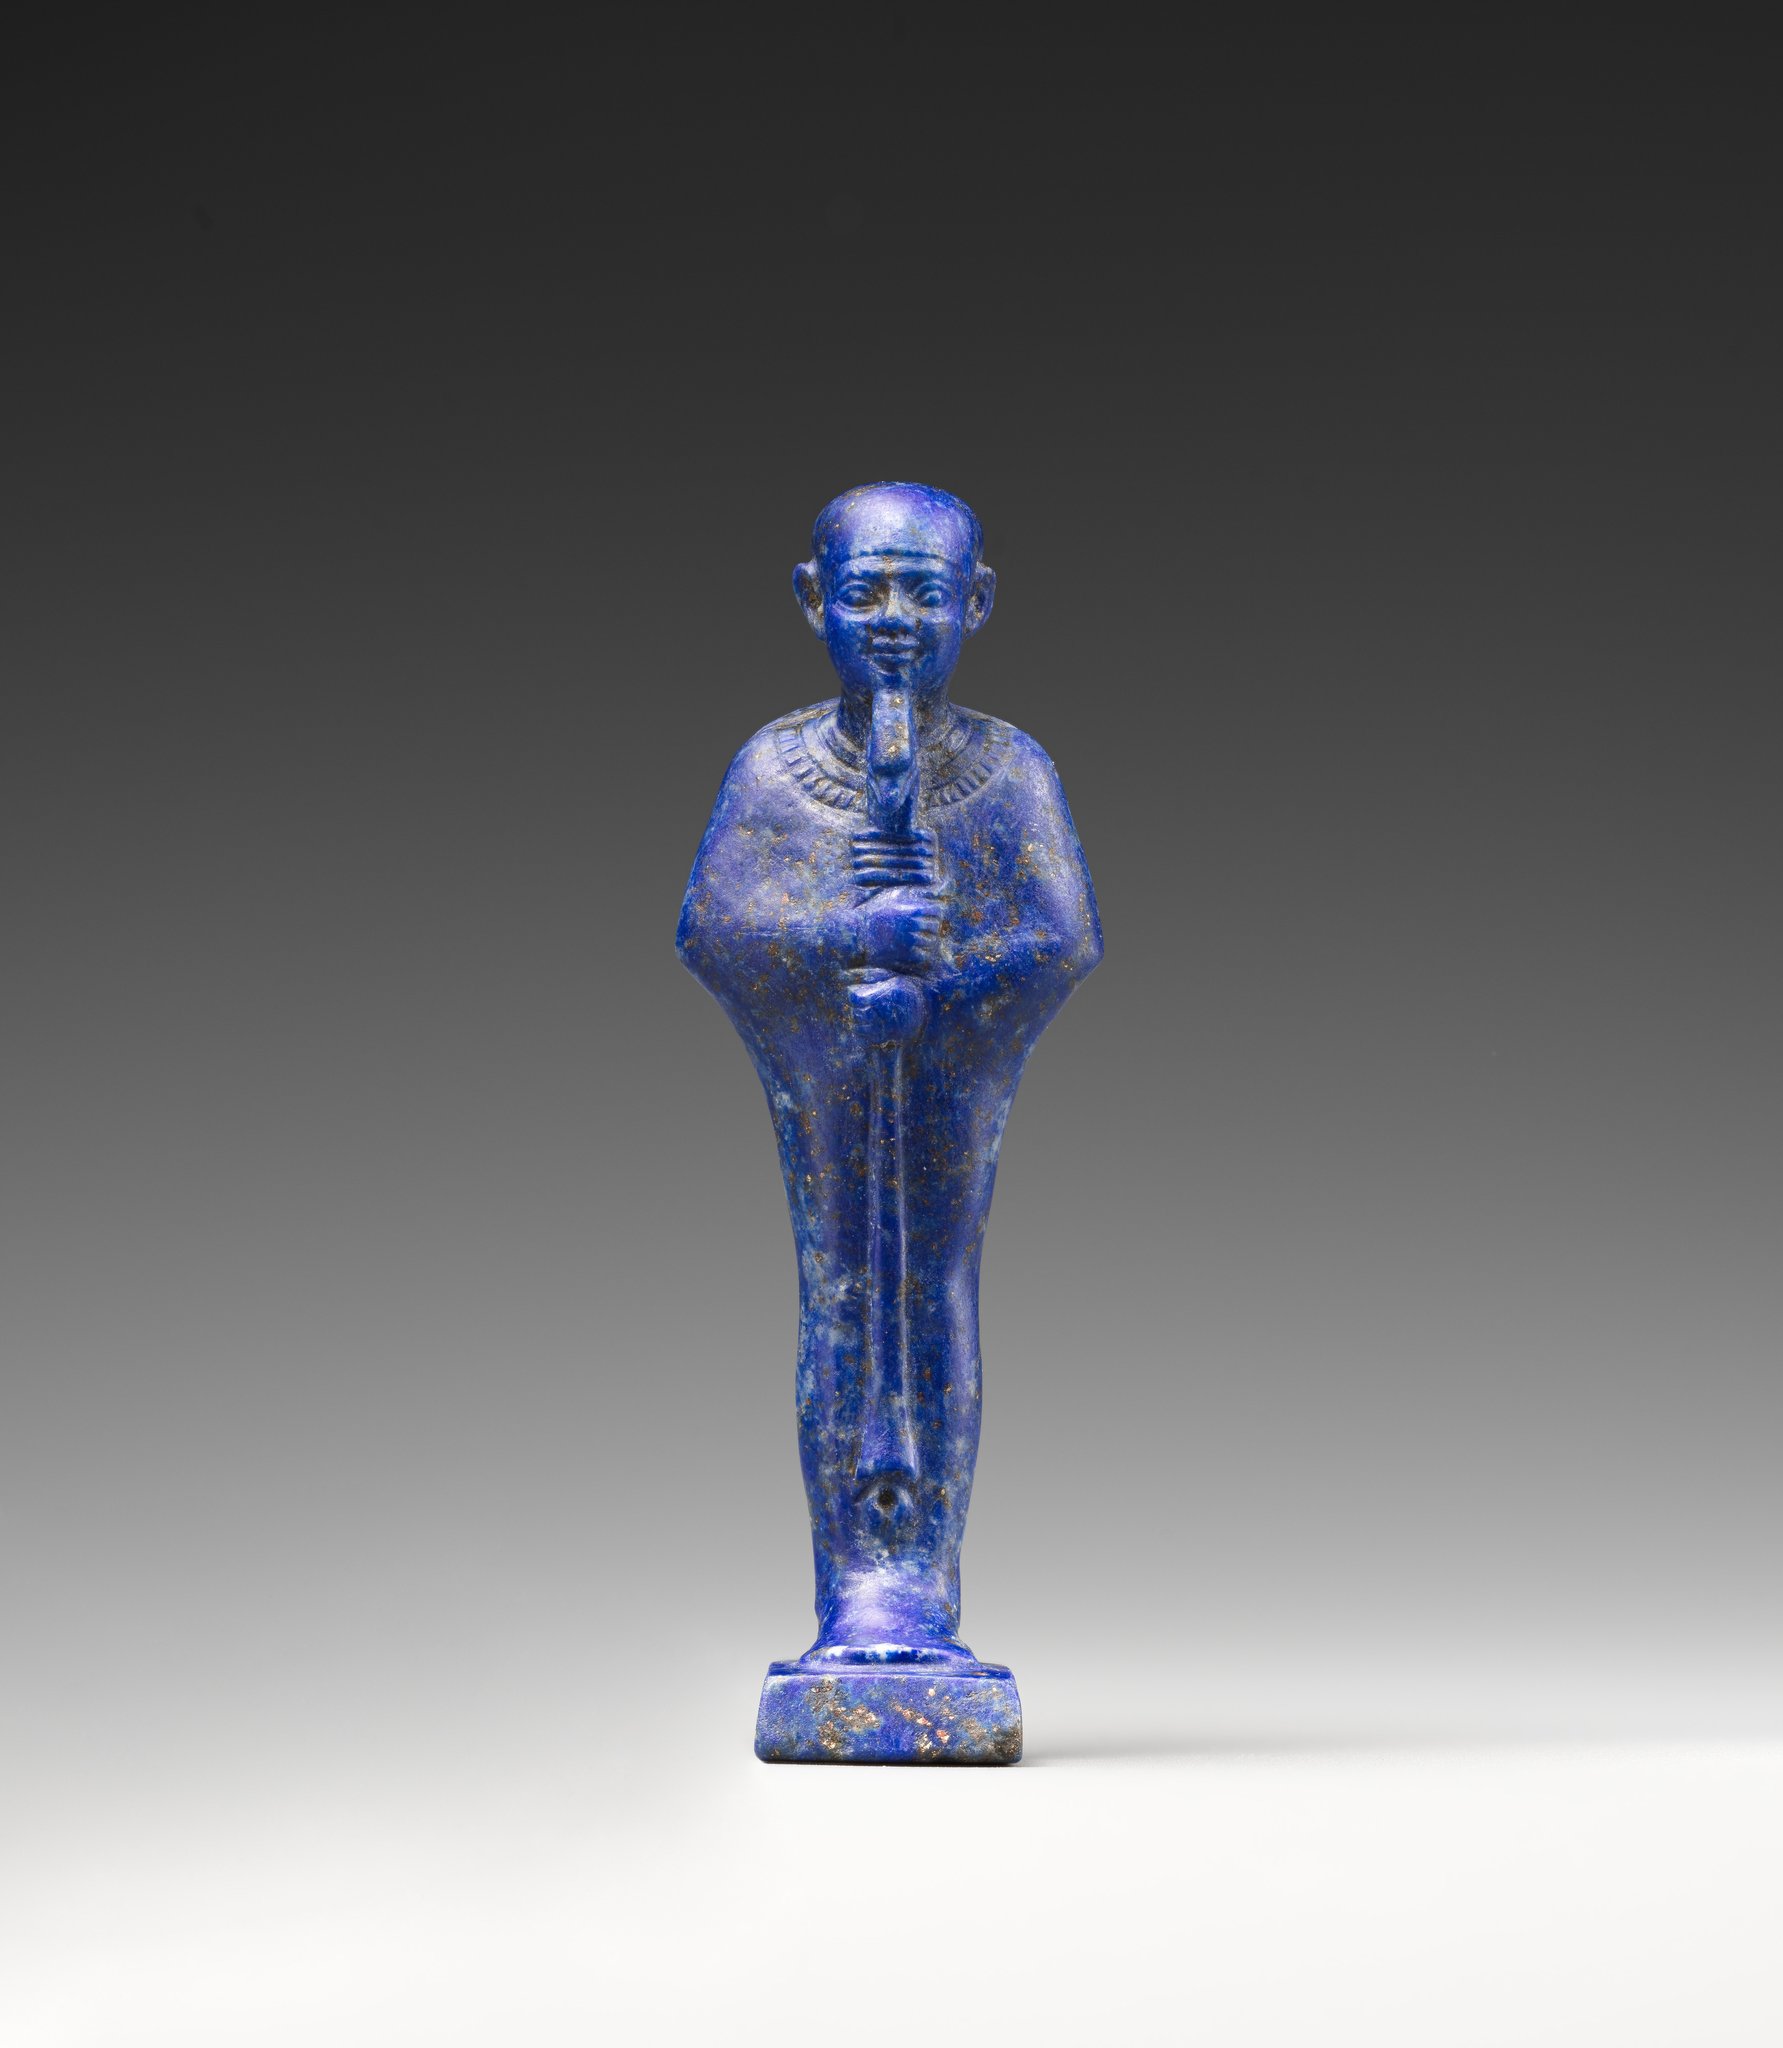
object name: statuette, ptah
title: Cult Image of the God Ptah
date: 945-600 BCE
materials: lapis lazuli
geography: egypt